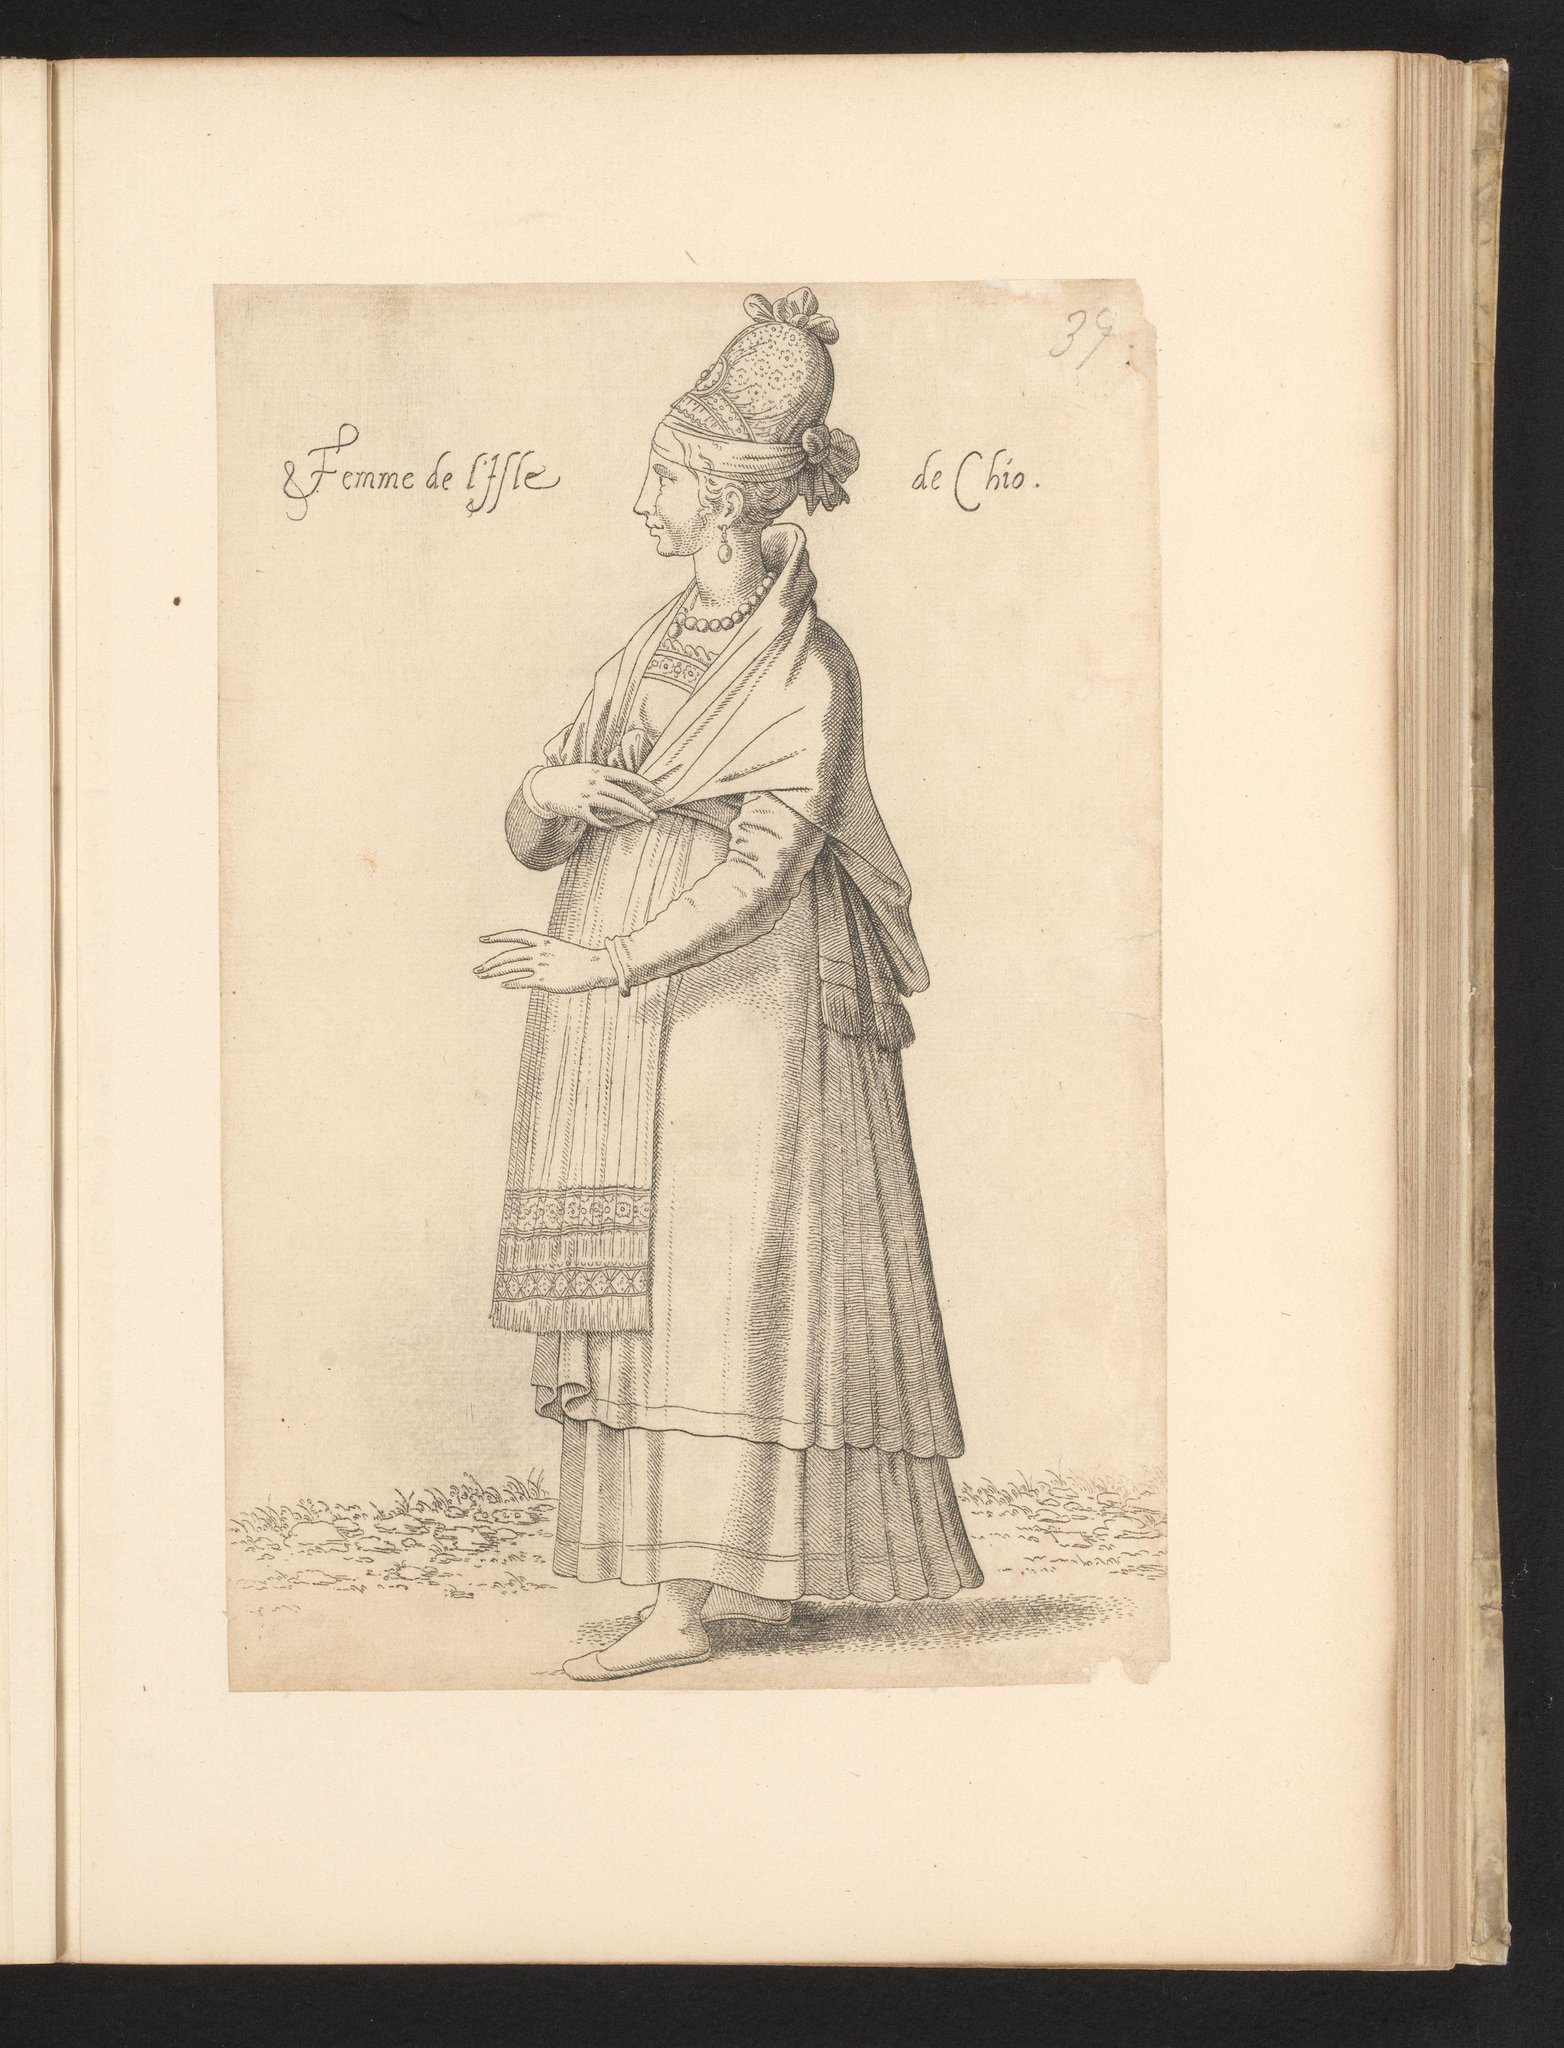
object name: print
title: Femme de l'isle de Chio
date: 1555-1568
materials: paper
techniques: etching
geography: lyon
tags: adult woman, europeans (with name), folk costume, regional costume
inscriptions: collector's mark: Lugt 2760, collector's mark: Lugt 2228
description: Prent uit: Nicolay, Nicolas de. Les quatre premiers livres des navigations et pérégrinations orientales, de N. de Nicolay, (...) Avec les figures au naturel tant d'hommes que de femmes selon la diversité des nations, & de leur port, maintien & habitz. Lyon: Guillaume (I) Rouille, 1568.